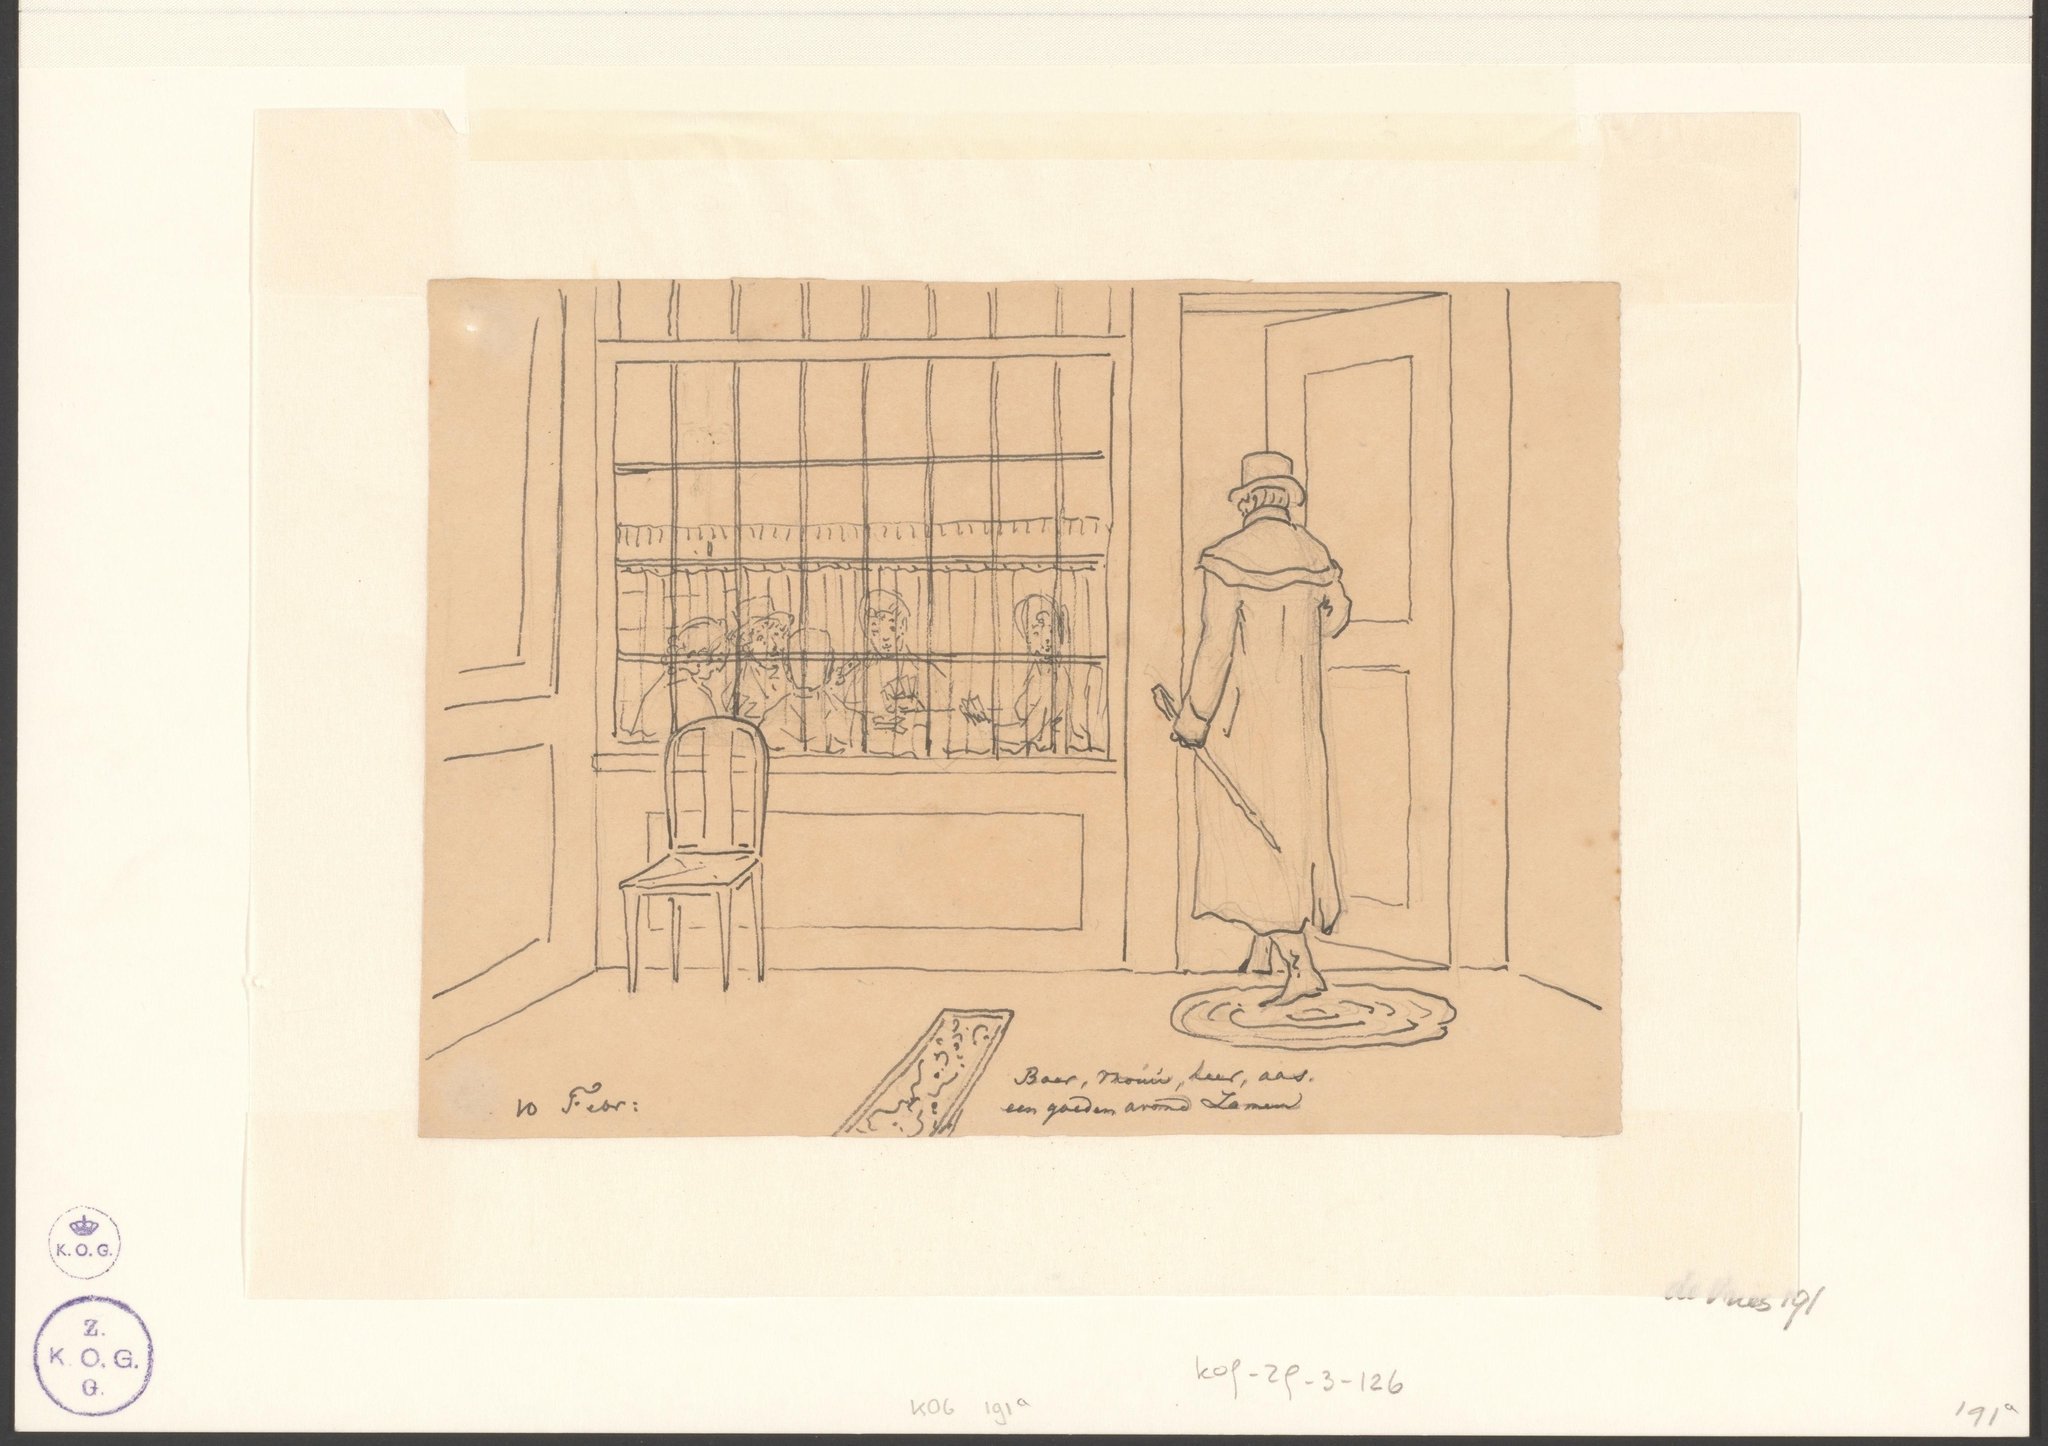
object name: print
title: Christiaan Andriessen kijkt naar kaartend gezelschap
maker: christiaan andriessen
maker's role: draughtsman, print maker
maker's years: 1775-1846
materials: ink, paper, pencil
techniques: pen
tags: amsterdam, print maker, draughtsman, christiaan andriessen, window, open door, walking-stick, staff, card games, head-gear: top hat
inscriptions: signature:, inscription: ‘10 Febr Boer, vrouw, heer, aas een goeden avond Zamen’, collector's mark: Lugt 1641a, collector's mark: Lugt 1641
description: Dagboekblad uit het getekende dagboek dat Christiaan Andriessen bijhield van 1805 tot en met 1808.